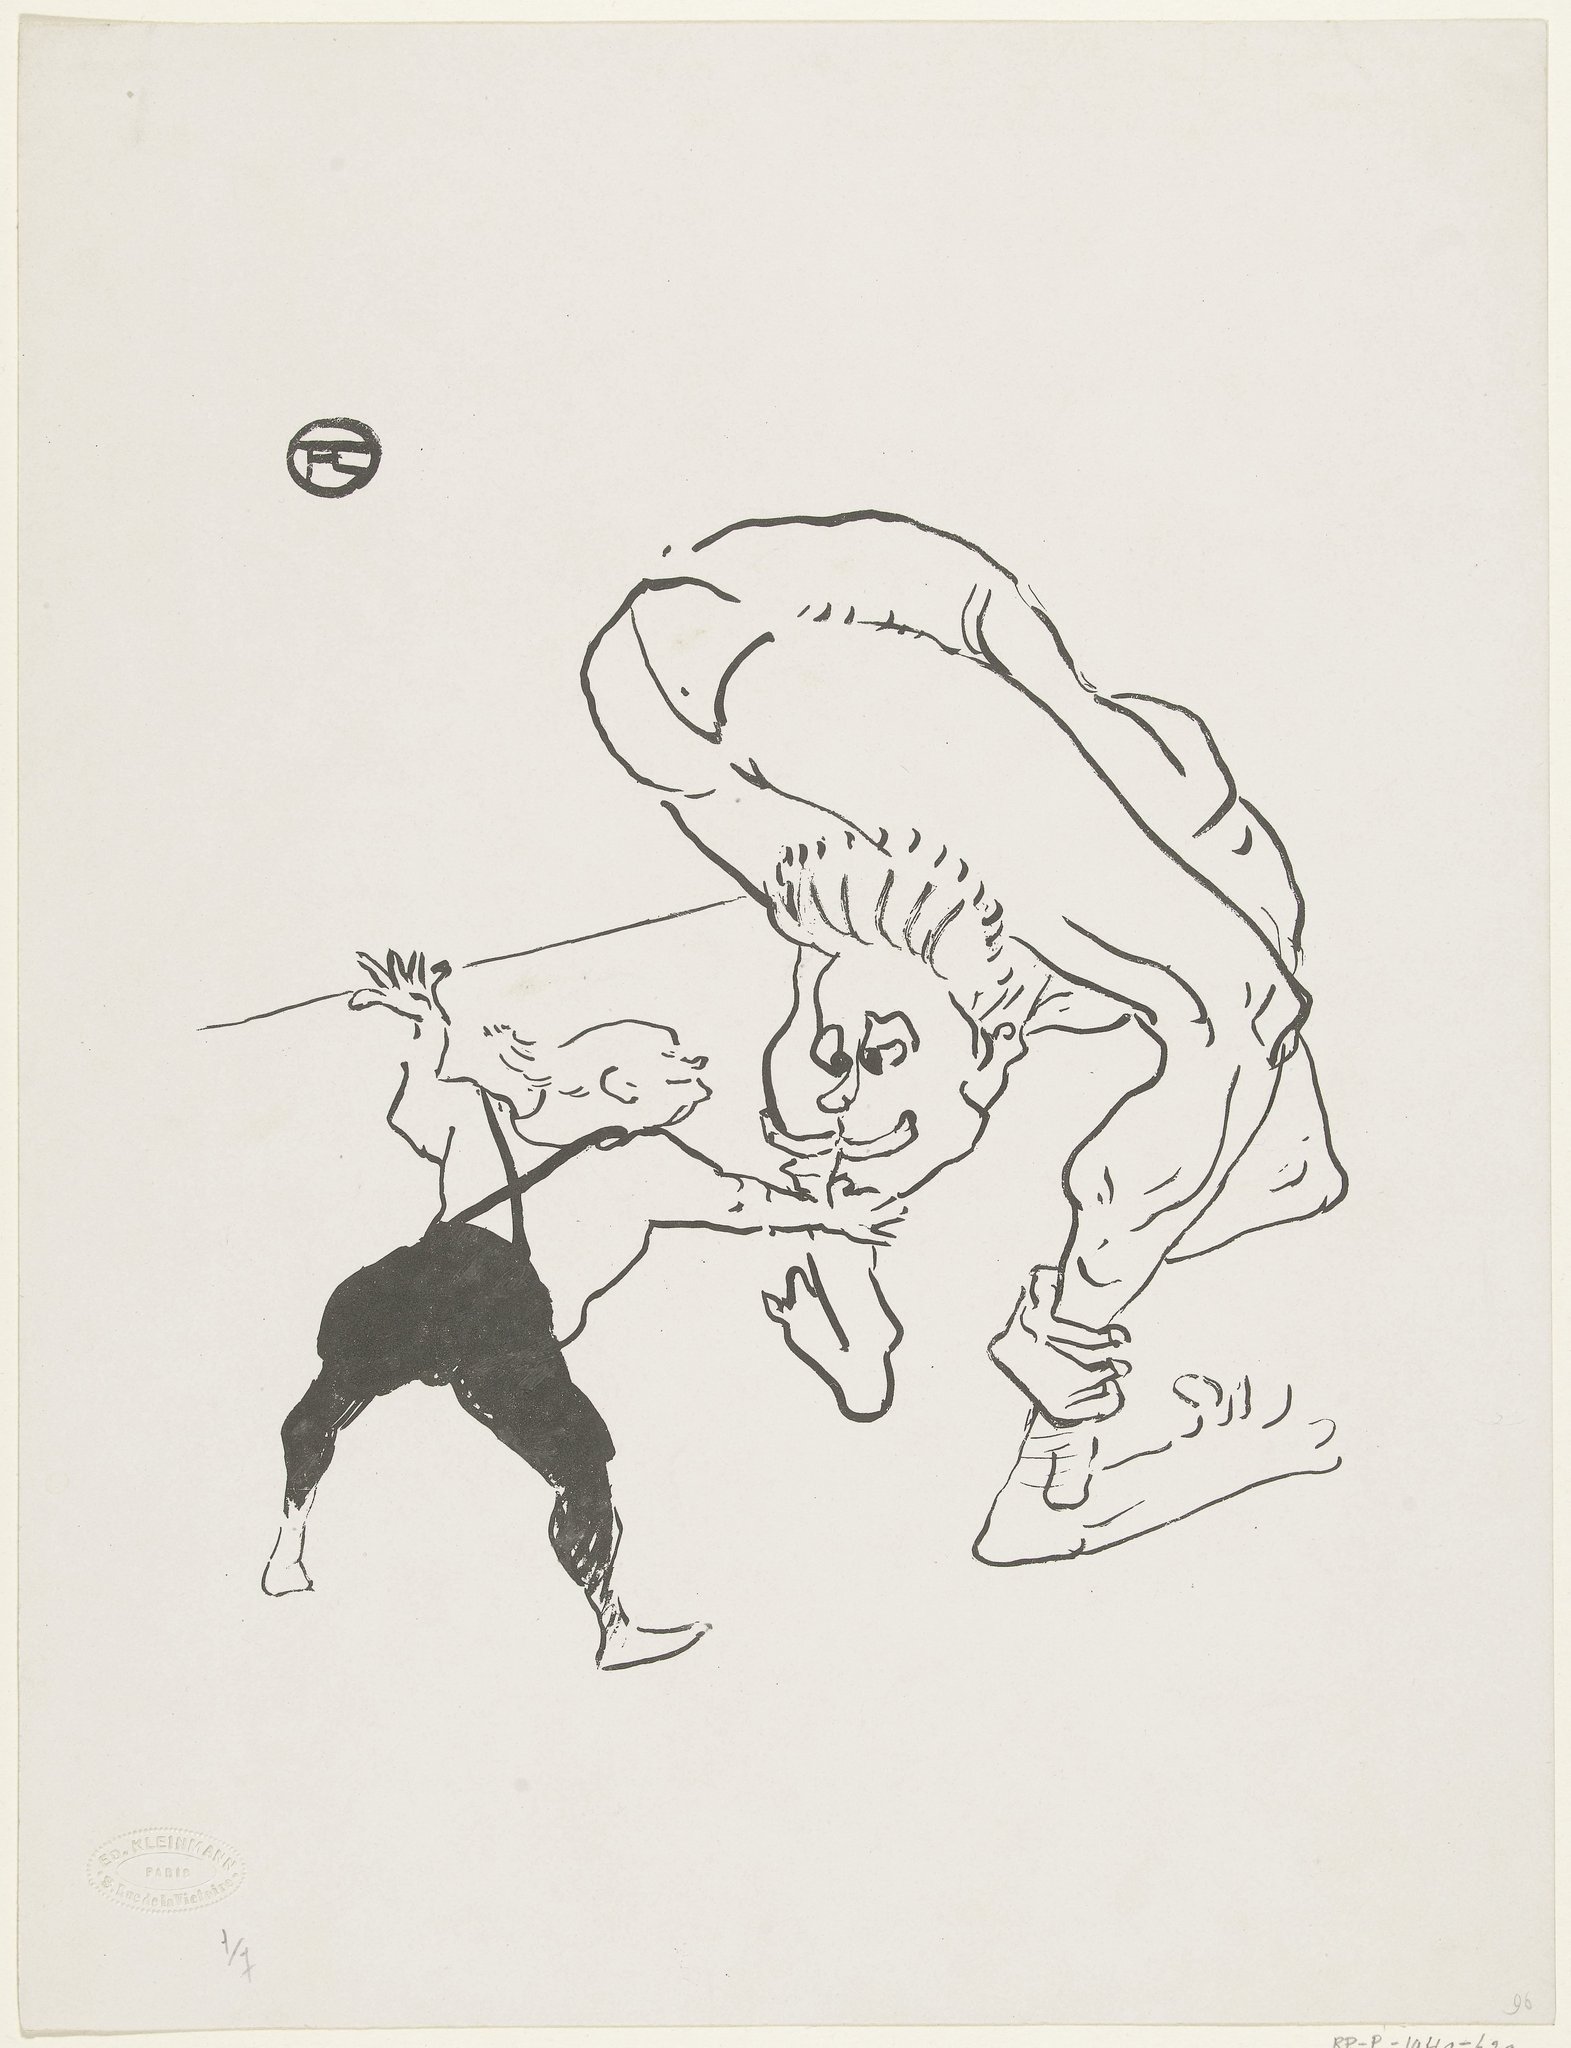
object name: photograph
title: Scène de Cirque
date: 1895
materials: paper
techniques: printing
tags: portrait of cabaret-artiste, cabaret-artiste, cabaret, cabaret (locality)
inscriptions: collector's mark: Lugt 2228, check stamp: Lugt 1573, collector's mark: Lugt 2760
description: Proefdruk voor reproductie in het satirisch tijdschrift Le Rire, Parijs, 22-12-1895. Toulouse-Lautrec maakte verschillende tekeningen voor reproducties in dit tijdschrift. Hij koos daarvoor onderwerpen uit het dagelijks leven maar ook beroemdheden. De illustratie in Le Rire is gedrukt in kleur. Dit werk wordt niet beschreven bij Wittrock 1985.